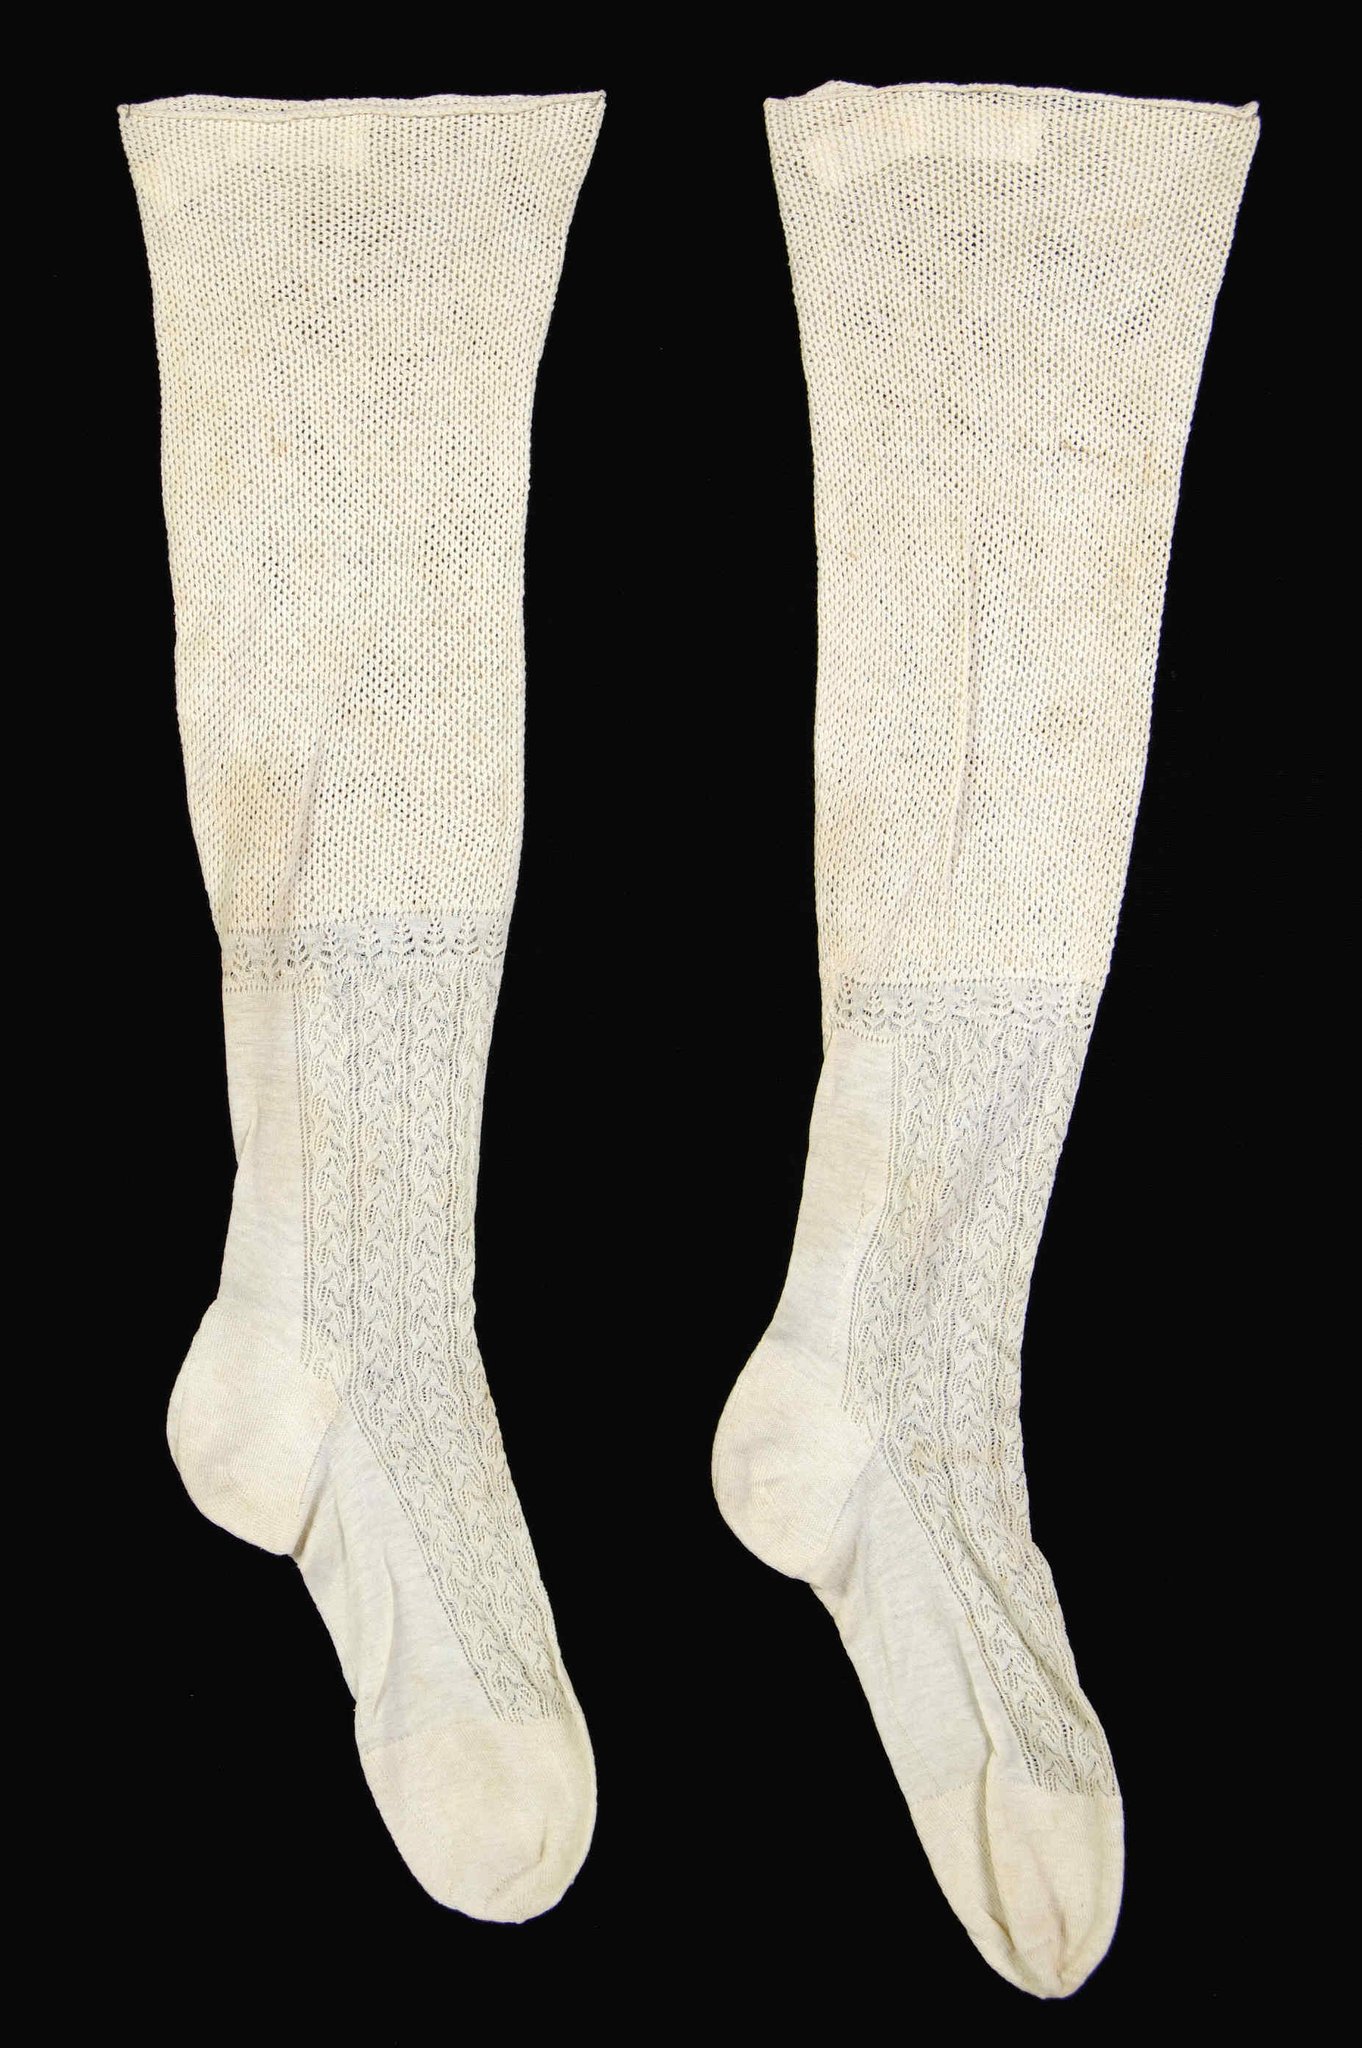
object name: stocking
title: Stockings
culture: american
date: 1870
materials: cotton